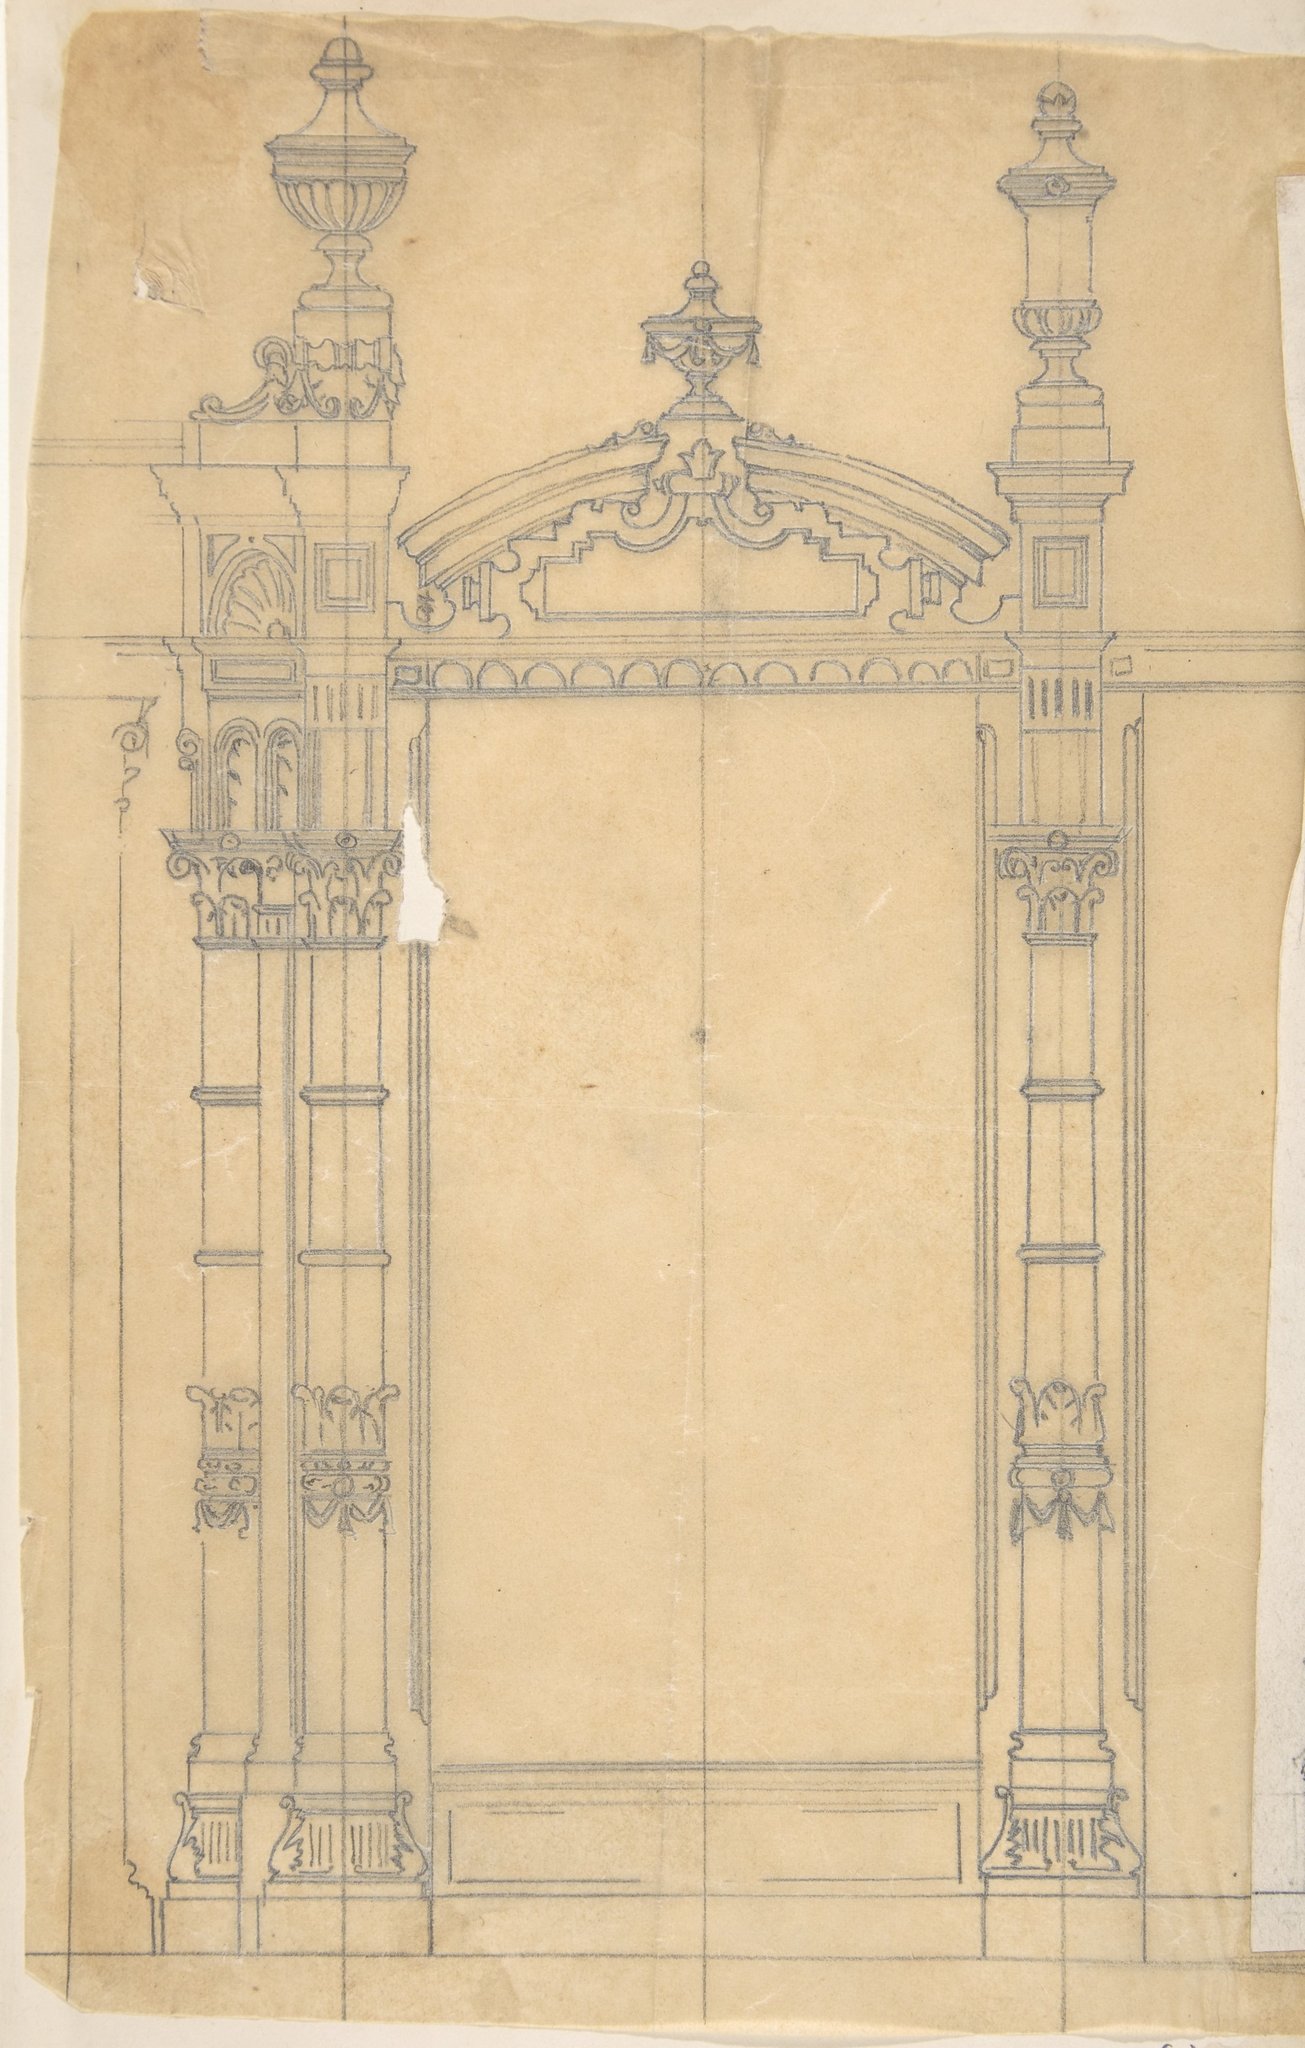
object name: drawing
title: Design for Grate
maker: anonymous, british, 19th century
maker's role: artist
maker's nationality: british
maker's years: 1800-1900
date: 1801-1900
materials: graphite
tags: architecture